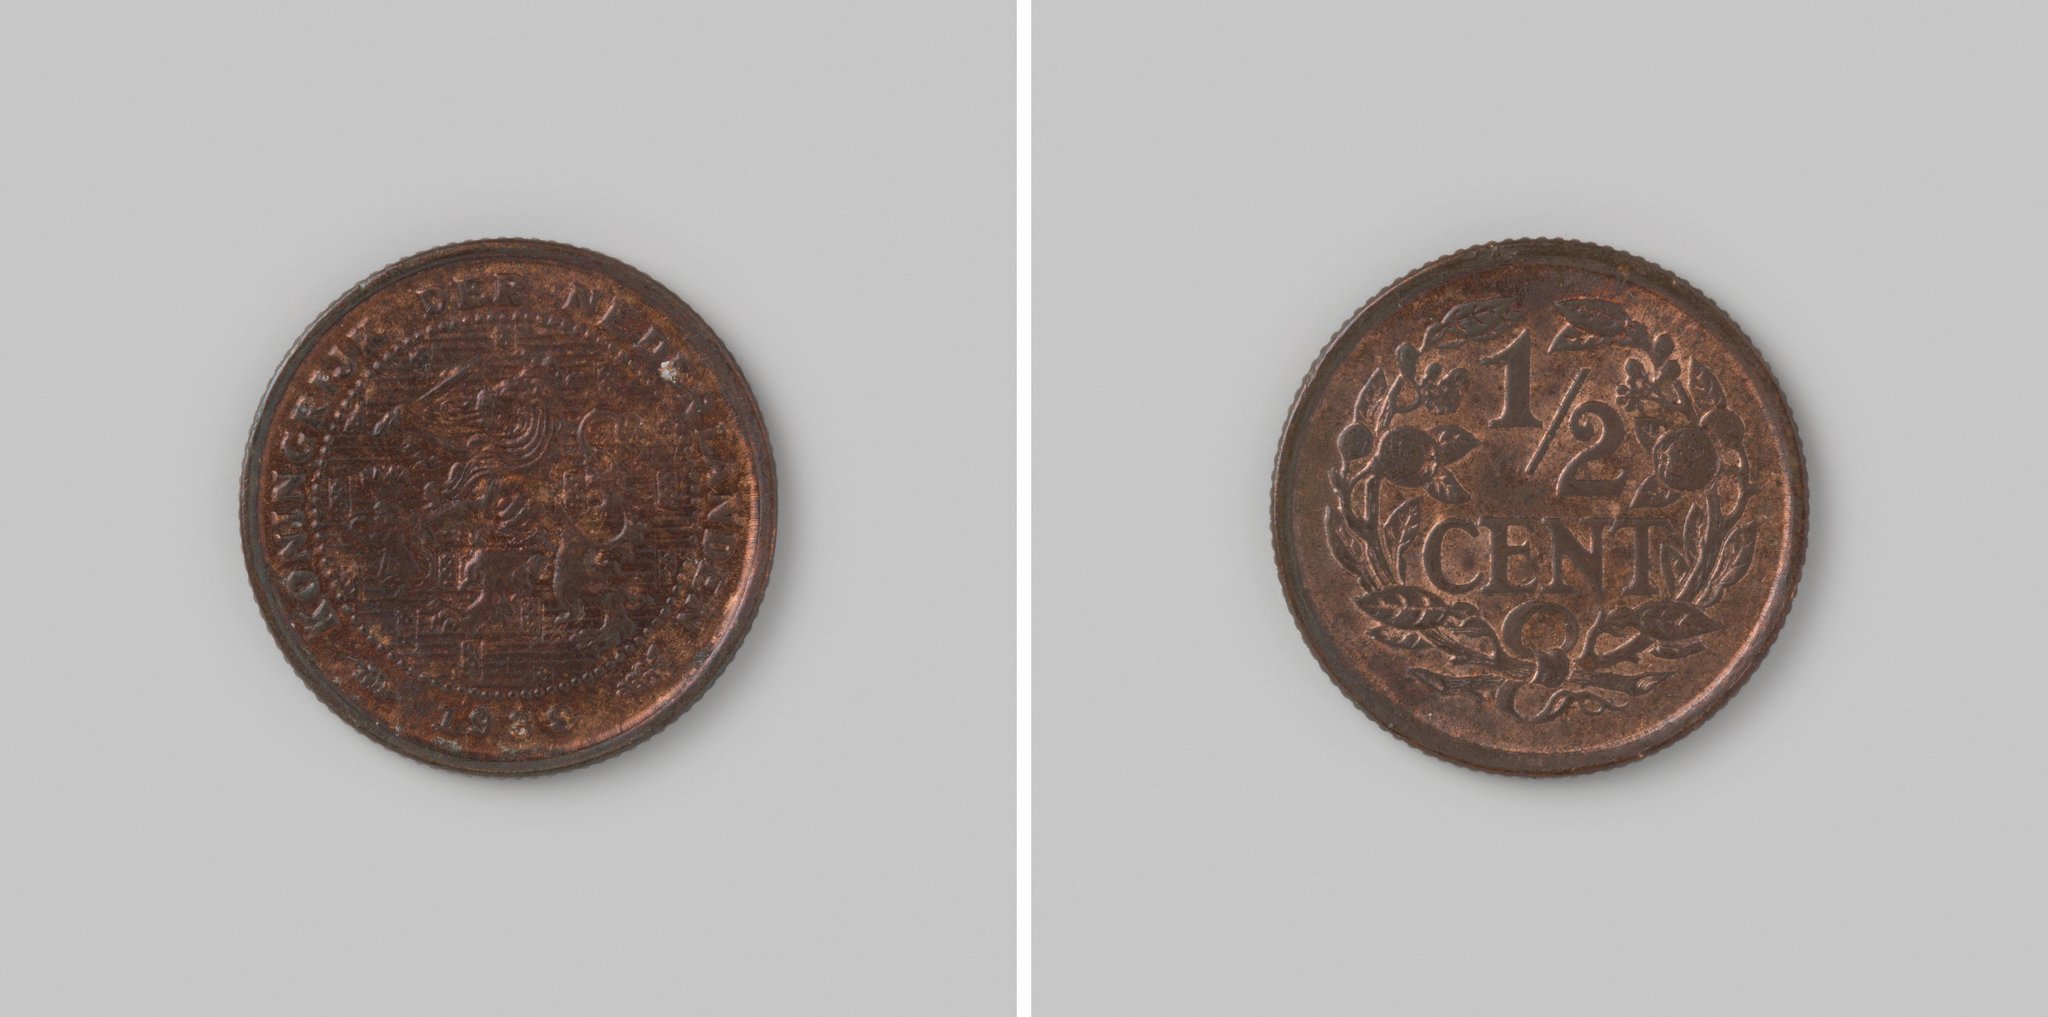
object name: coin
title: Nederlandse ½ cent, 1938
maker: wilhelmina of the netherlands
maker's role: print maker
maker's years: 1880-1962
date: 1938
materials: bronze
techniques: striking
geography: utrecht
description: Bronzen munt. Voorzijde: in een veld rijkswapen. Jaartal onderaan in omschrift. Keerzijde: binnen twee samengebonden oranjetakken waarde-aanduiding ½ cent. Kartelrand.